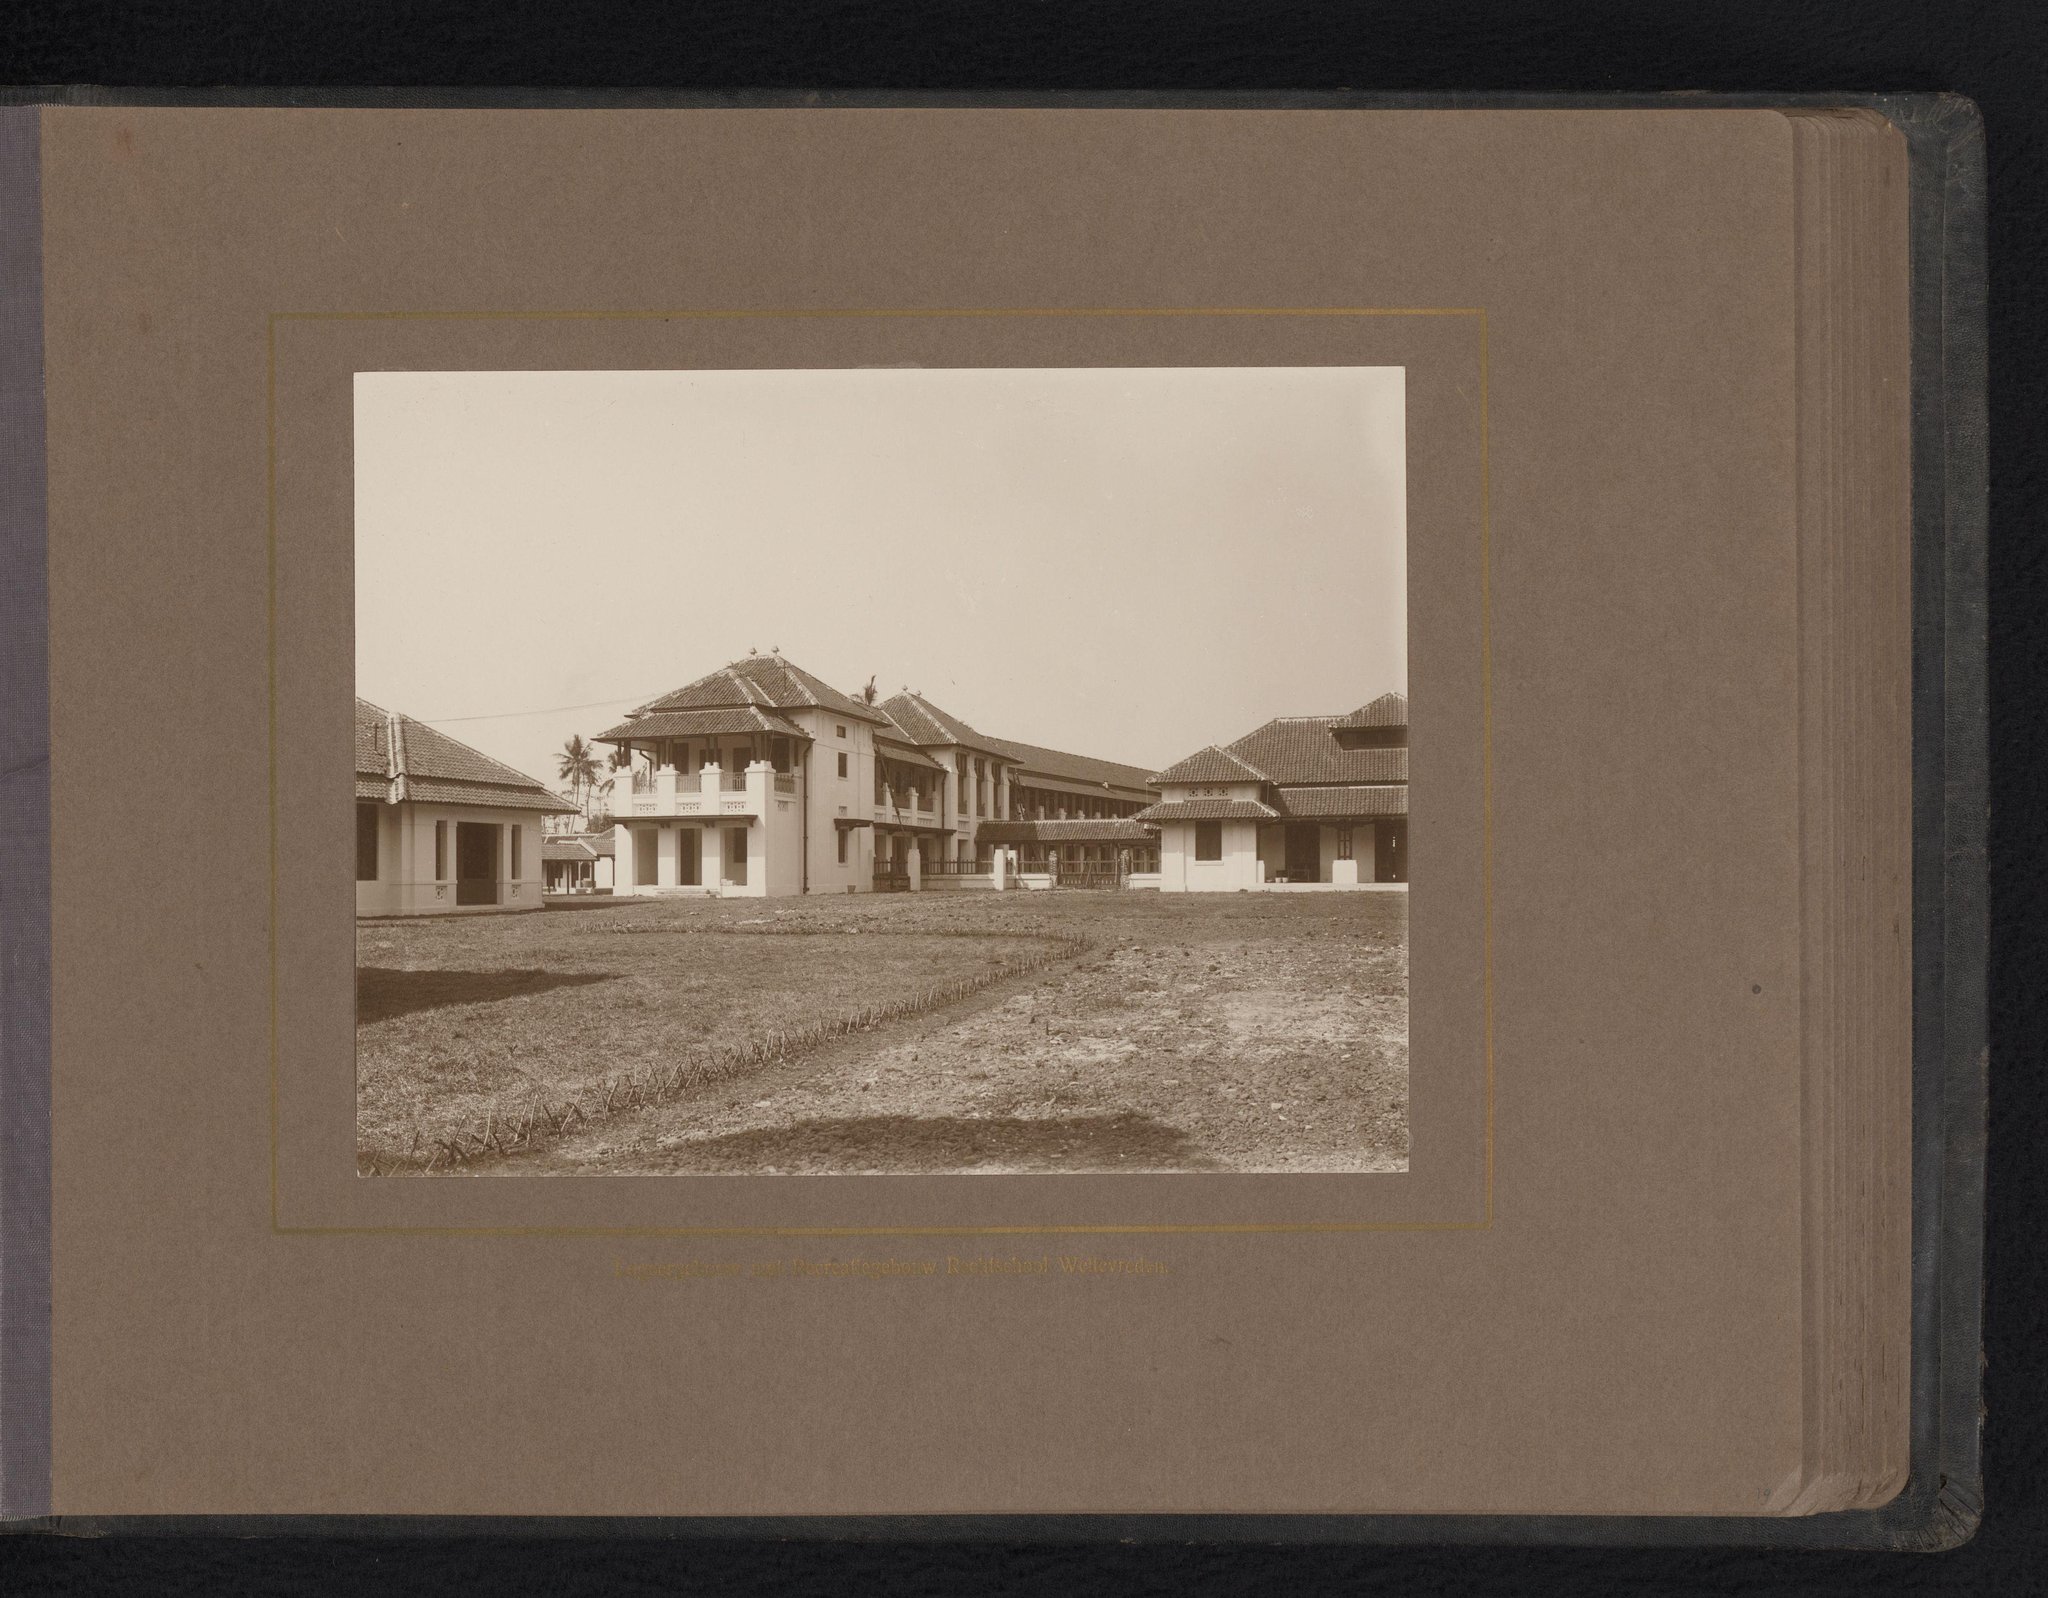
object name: photograph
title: Logeergebouw met Recreatiegebouw Rechtschool Weltevreden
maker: Anonymous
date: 1918-1919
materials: photographic support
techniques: gelatin silver print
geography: batavia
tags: further education (+ building ~ education, tuition), batavia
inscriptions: inscription: ‘Logeergebouw met Recreatiegebouw Rechtschool Weltevreden’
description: Het logeergebouw en het recreatiegebouw bij de Rechtschool te Weltevreden. Onderdeel van het fotoalbum van de Eerste Waterstaatsafdeling op West-Java 22 maart 1915 - 30 juli 1919.